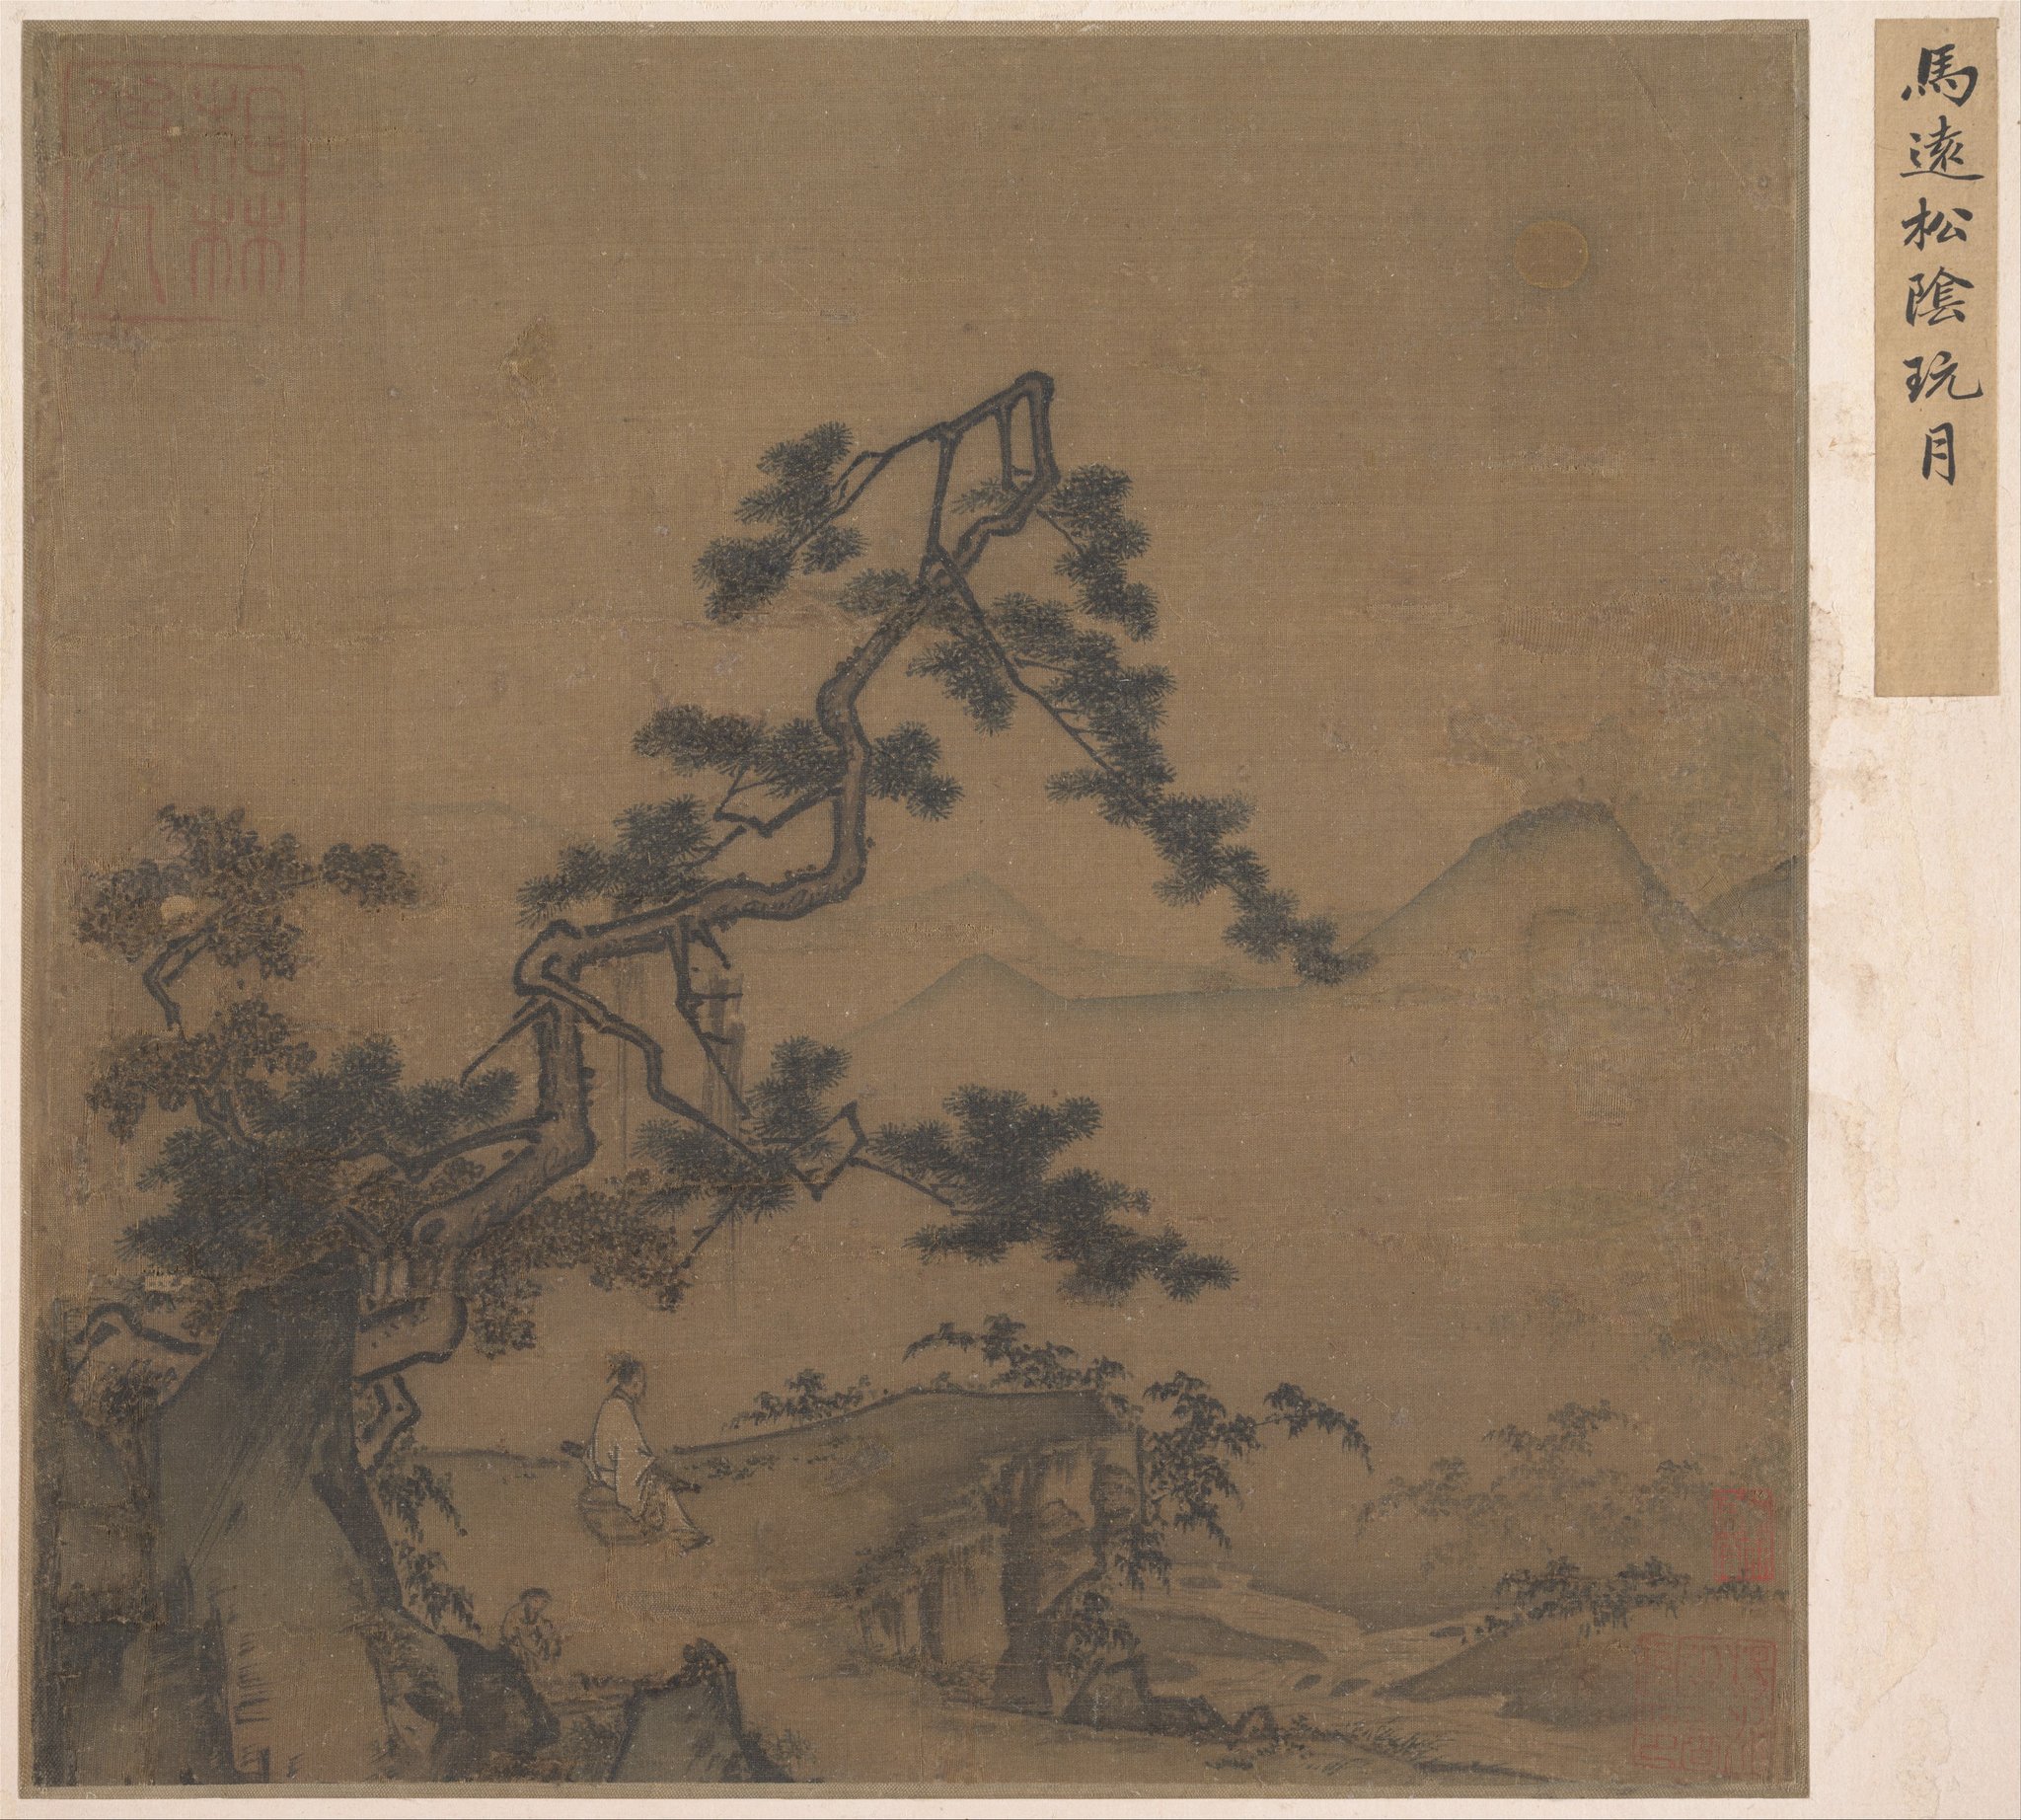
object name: album leaf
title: Viewing the Moon under a Pine Tree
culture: chinese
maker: ma yuan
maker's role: artist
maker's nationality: chinese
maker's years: 1190-1225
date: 1201-1233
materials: ink, silk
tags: landscapes,trees